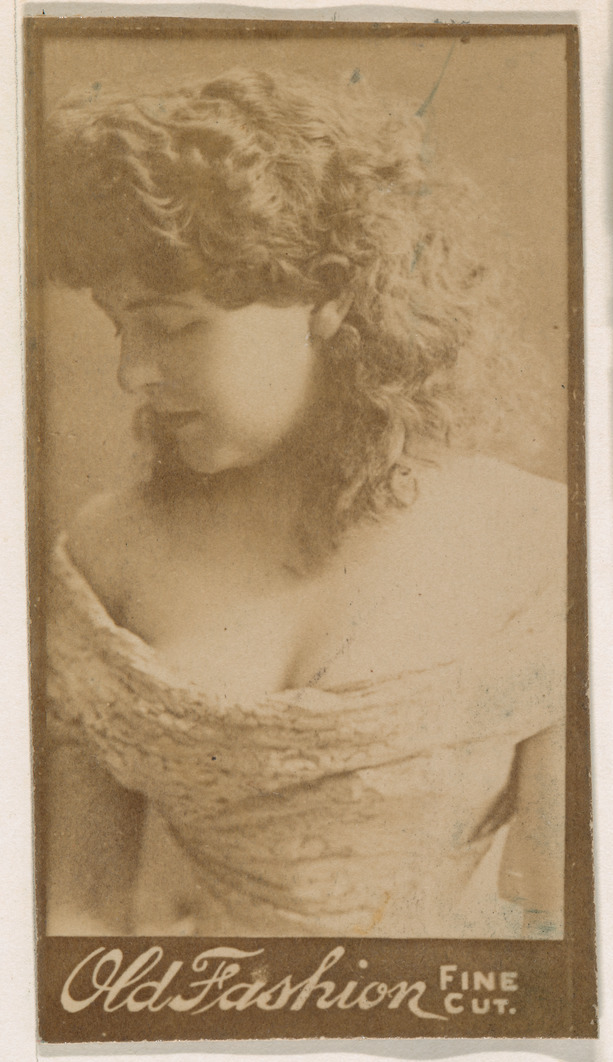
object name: photograph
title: Portrait of actress in profile, from the Actresses series (N664) promoting Old Fashion Fine Cut Tobacco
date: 1888-1890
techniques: albumen silver print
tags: portraits,women,actresses